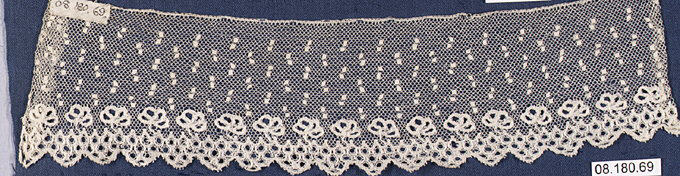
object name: fragment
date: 1801-1900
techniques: lace